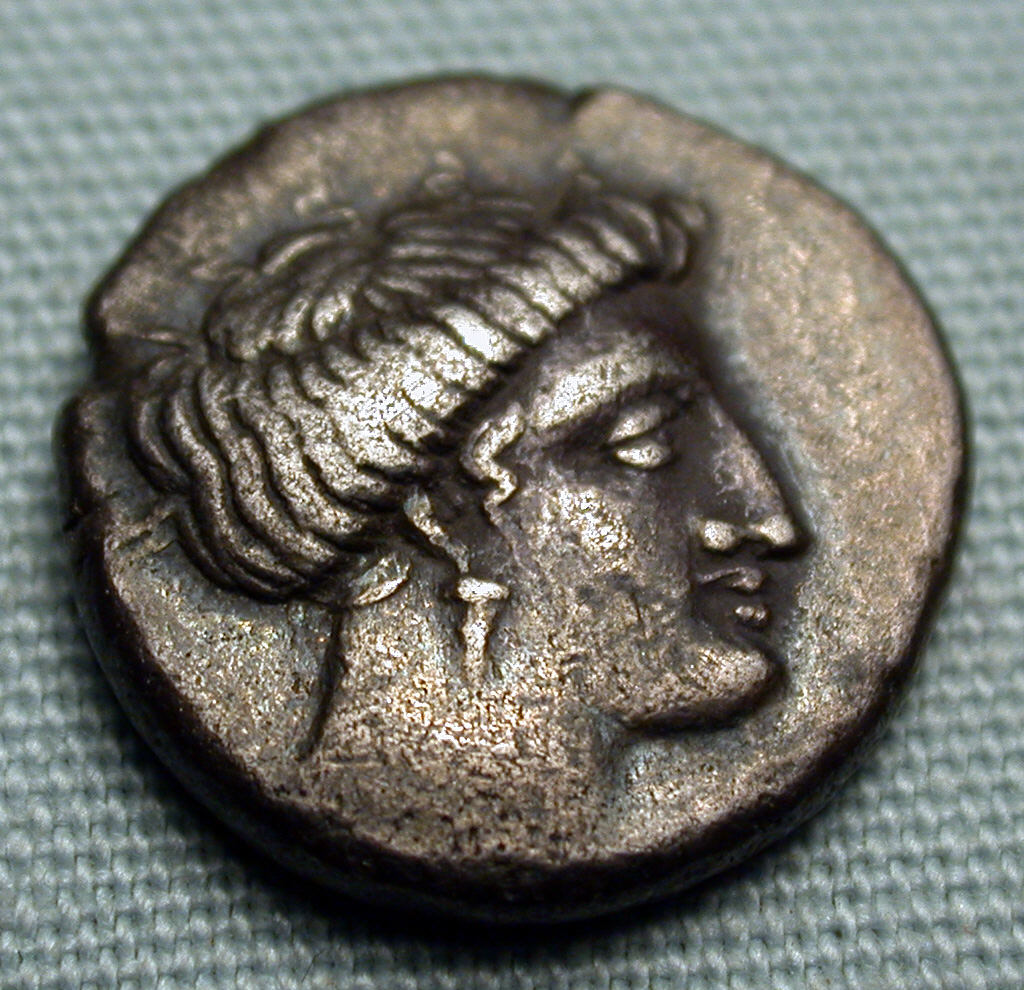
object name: drachm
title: Silver drachm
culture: greek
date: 338-308 BCE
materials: silver